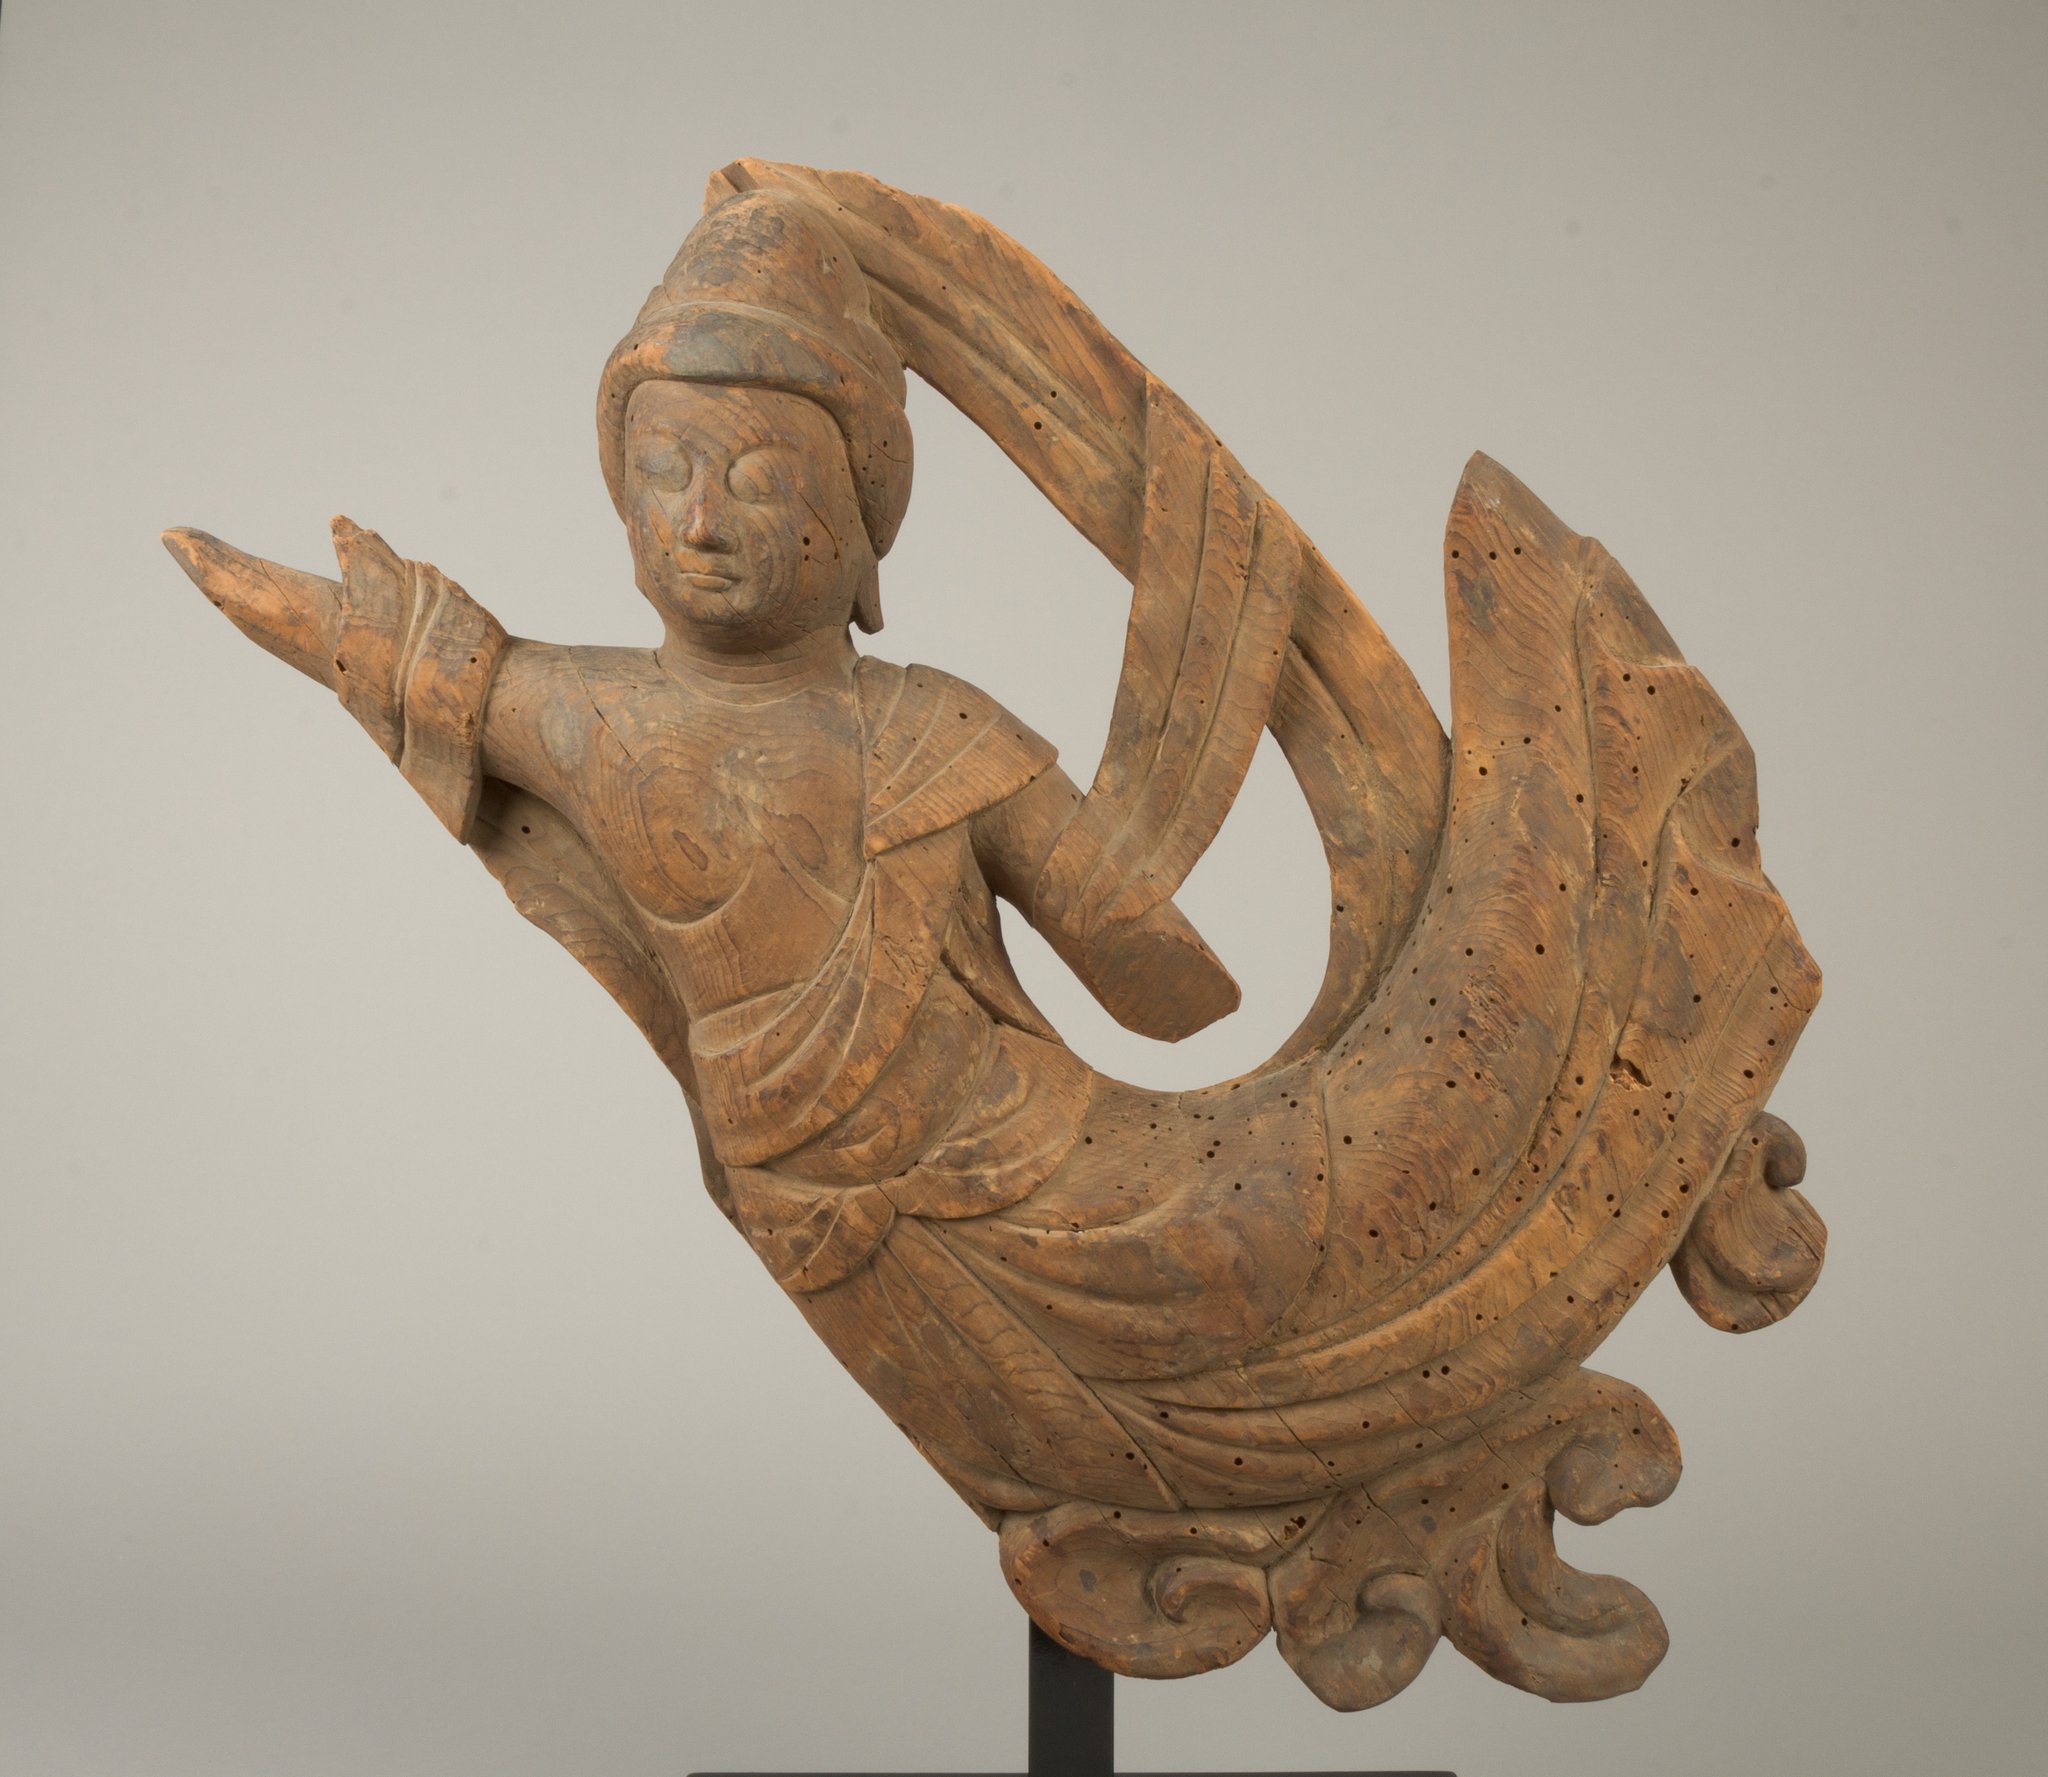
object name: figure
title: Hiten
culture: japanese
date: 901-1000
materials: wood